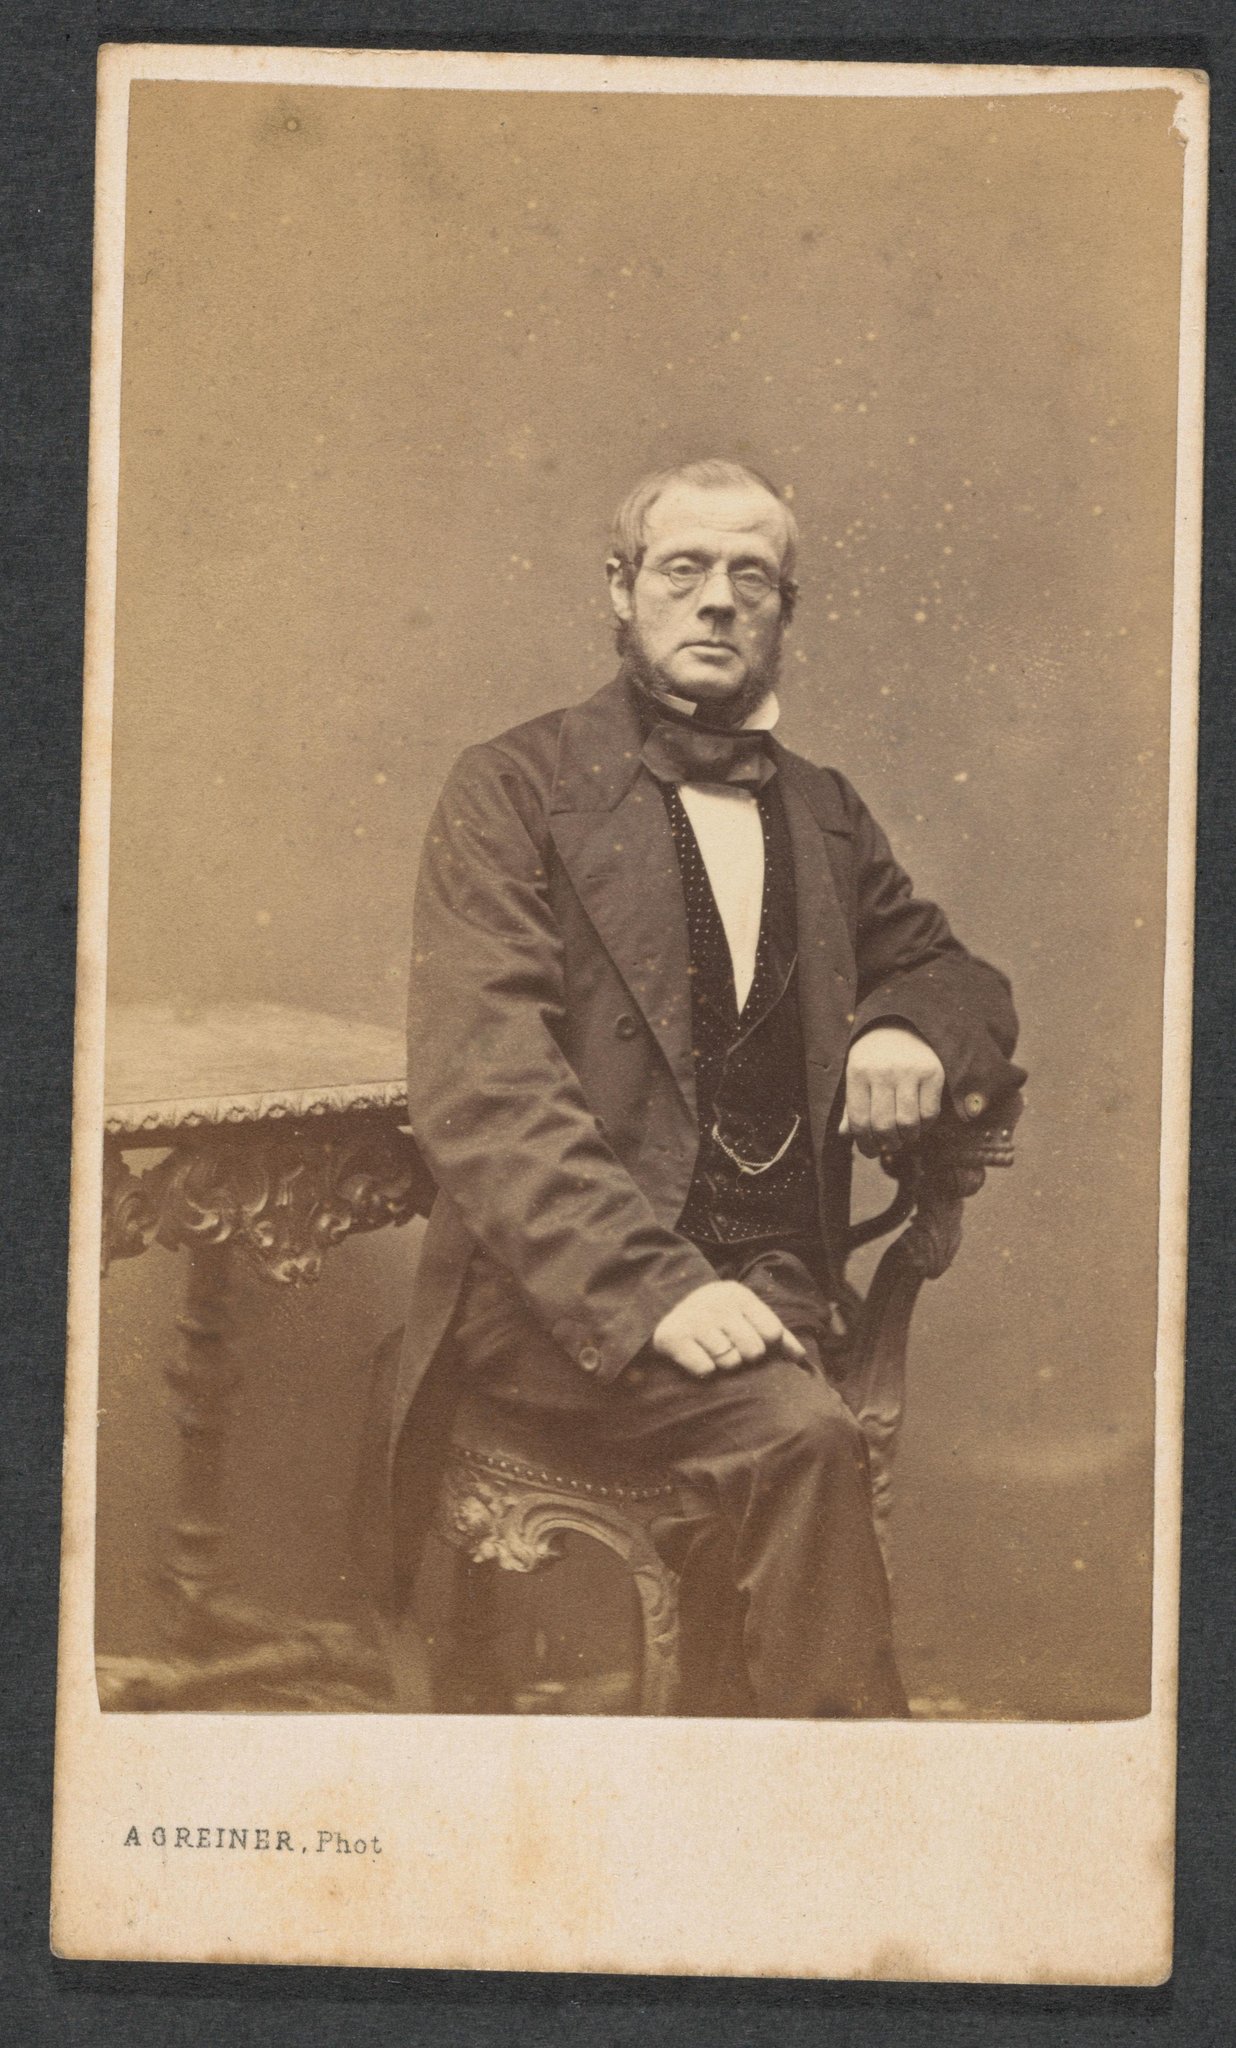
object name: carte de visite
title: Portret van een onbekende man uit de familie Marmelstein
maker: albert greiner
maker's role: fotograaf, fotostudio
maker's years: 1833-1890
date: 1861-1874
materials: cardboard, photographic support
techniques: albumen print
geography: amsterdam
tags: historical persons not known by name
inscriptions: address: ‘A. Greiner/ Photograf/ Nieuwendijk L. 87./ Amsterdam’